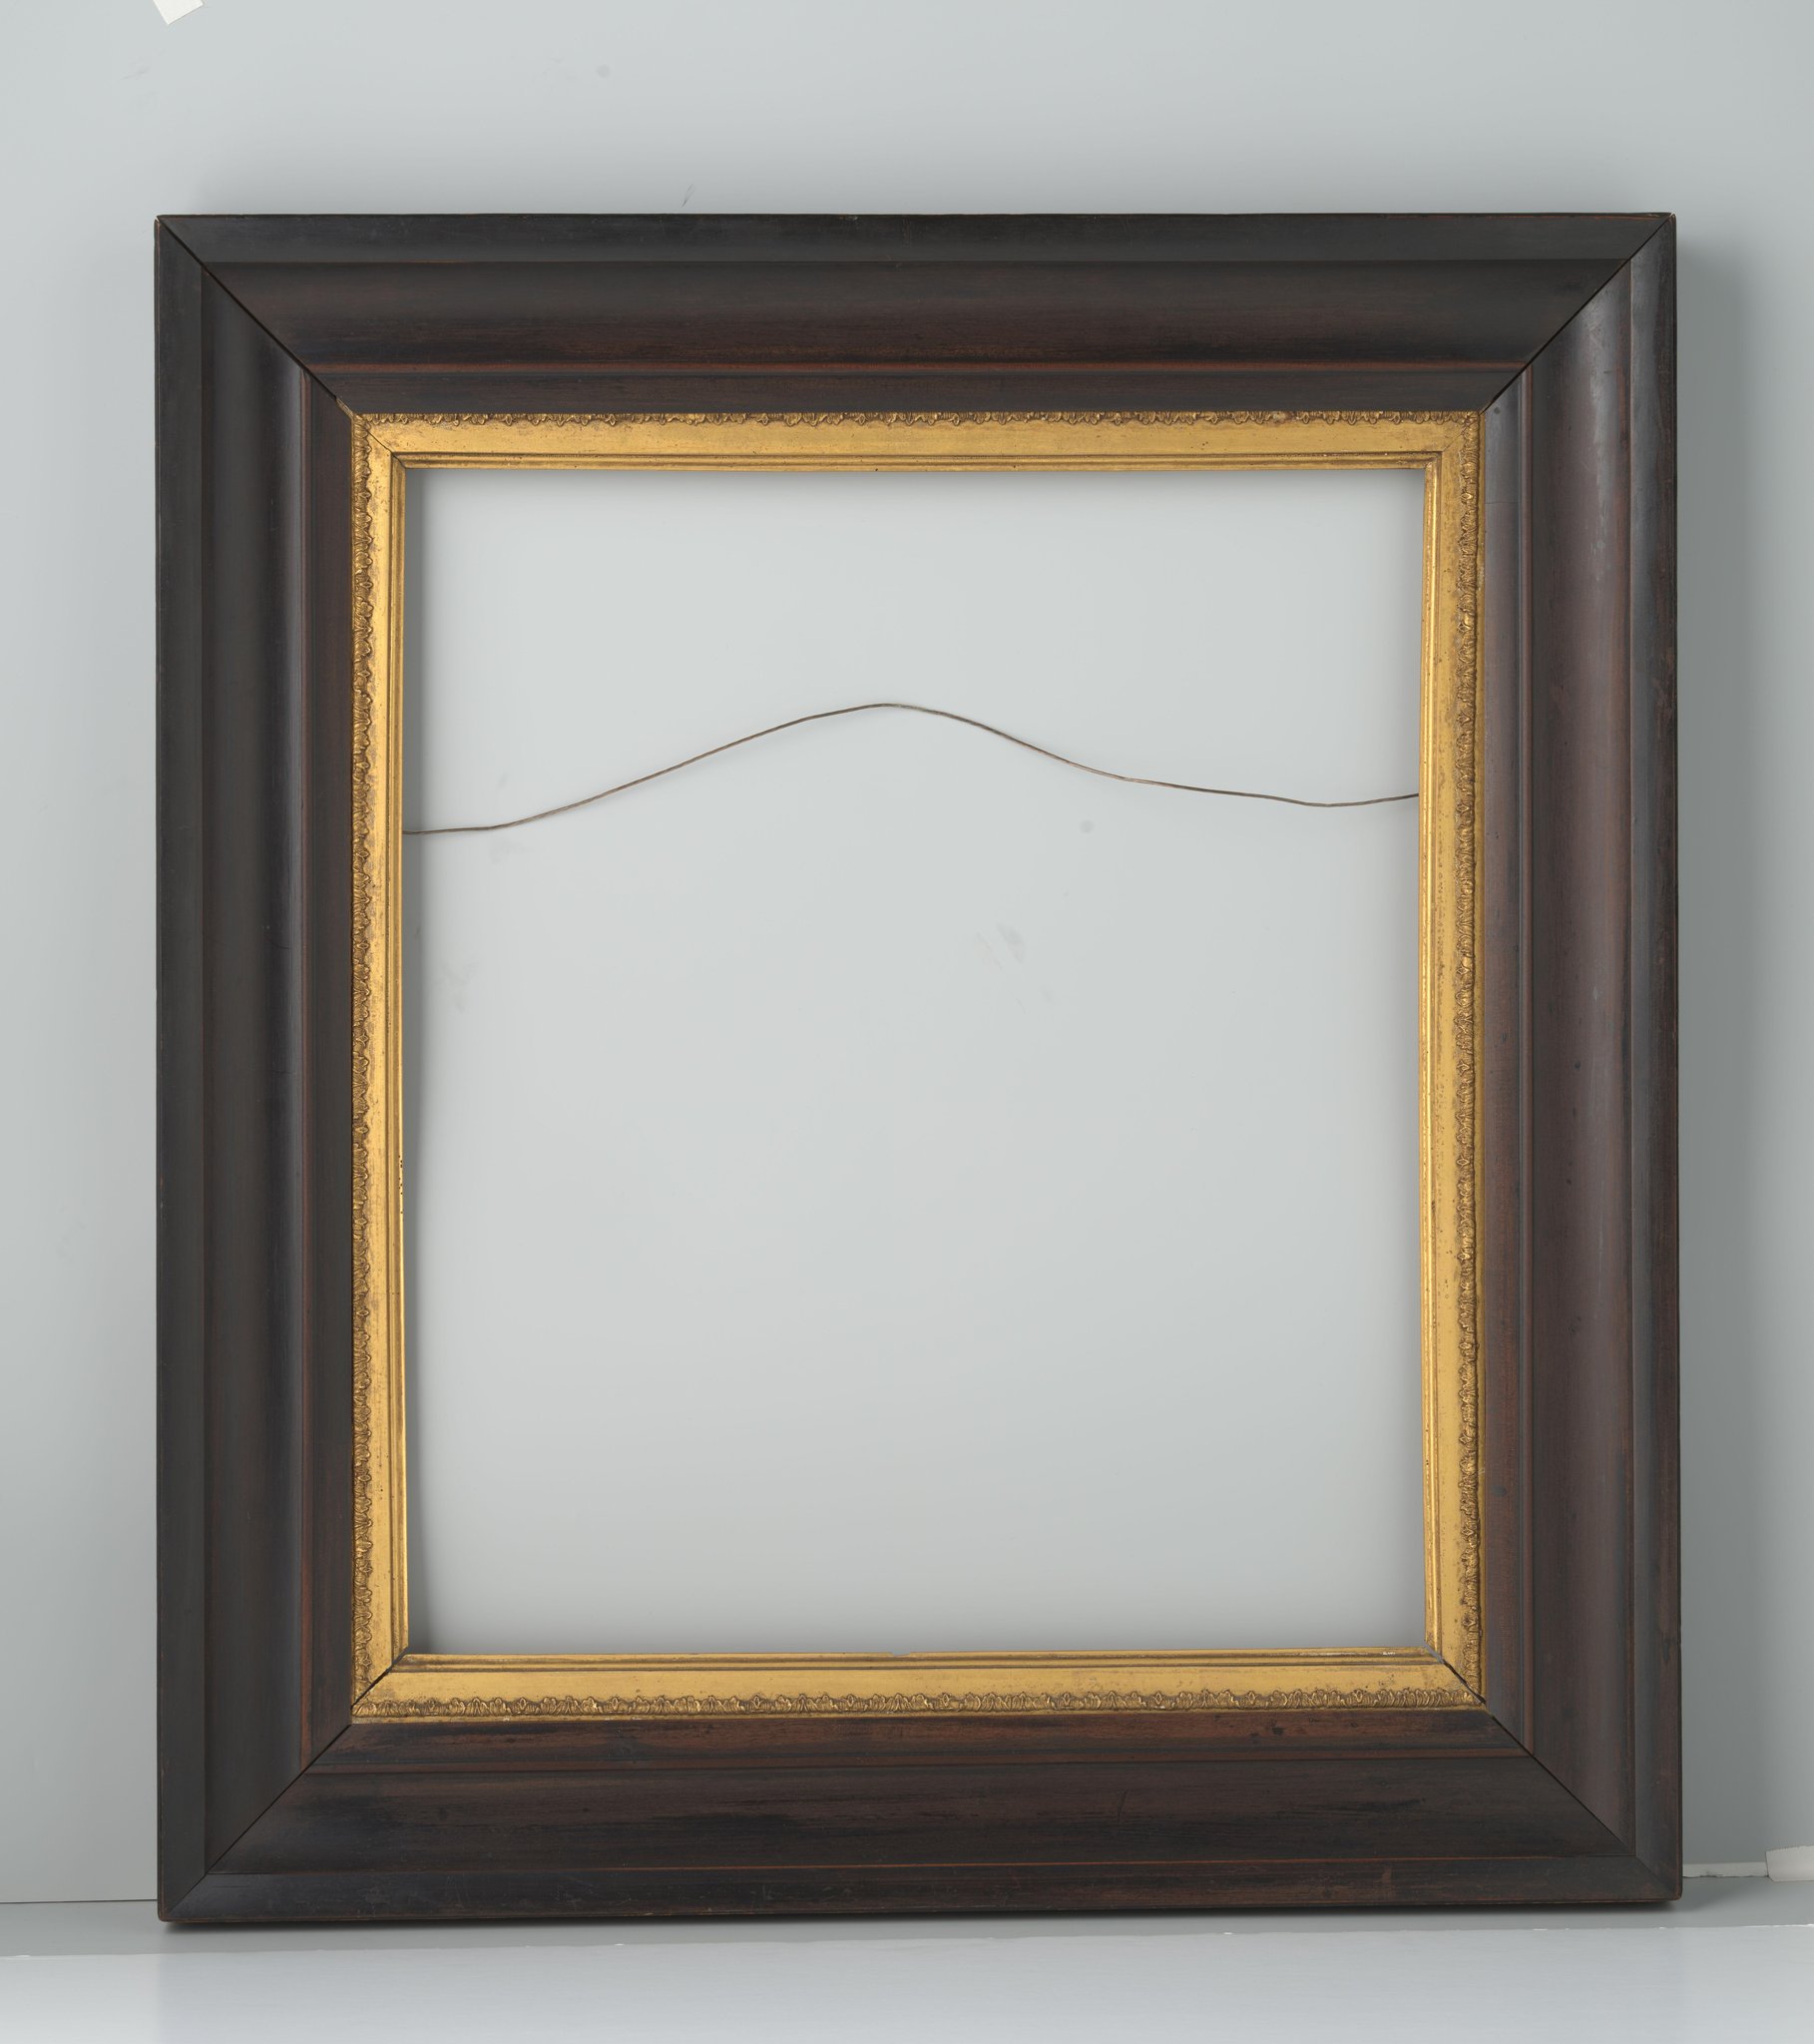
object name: frame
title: Bruine profiellijst met notenhouten profileringen en fineer op een naaldhouten zool. Een vergulde binnenlijst met pâte-ornamenten met bladmotief is met spijkers in het buitenste profiel bevestigd. Het buitenste profiel is een vermaakte 17e eeuwse profiellijst. De onderste hoeken hebben een halfhoutverbinding, de bovenste hoeken zijn verzaagd en verstekt met spijkers. De vergulde binnenlijst is een latere toevoeging.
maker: Anonymous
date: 1849-1899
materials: gold leaf, wood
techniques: gilding, veneer, veneering